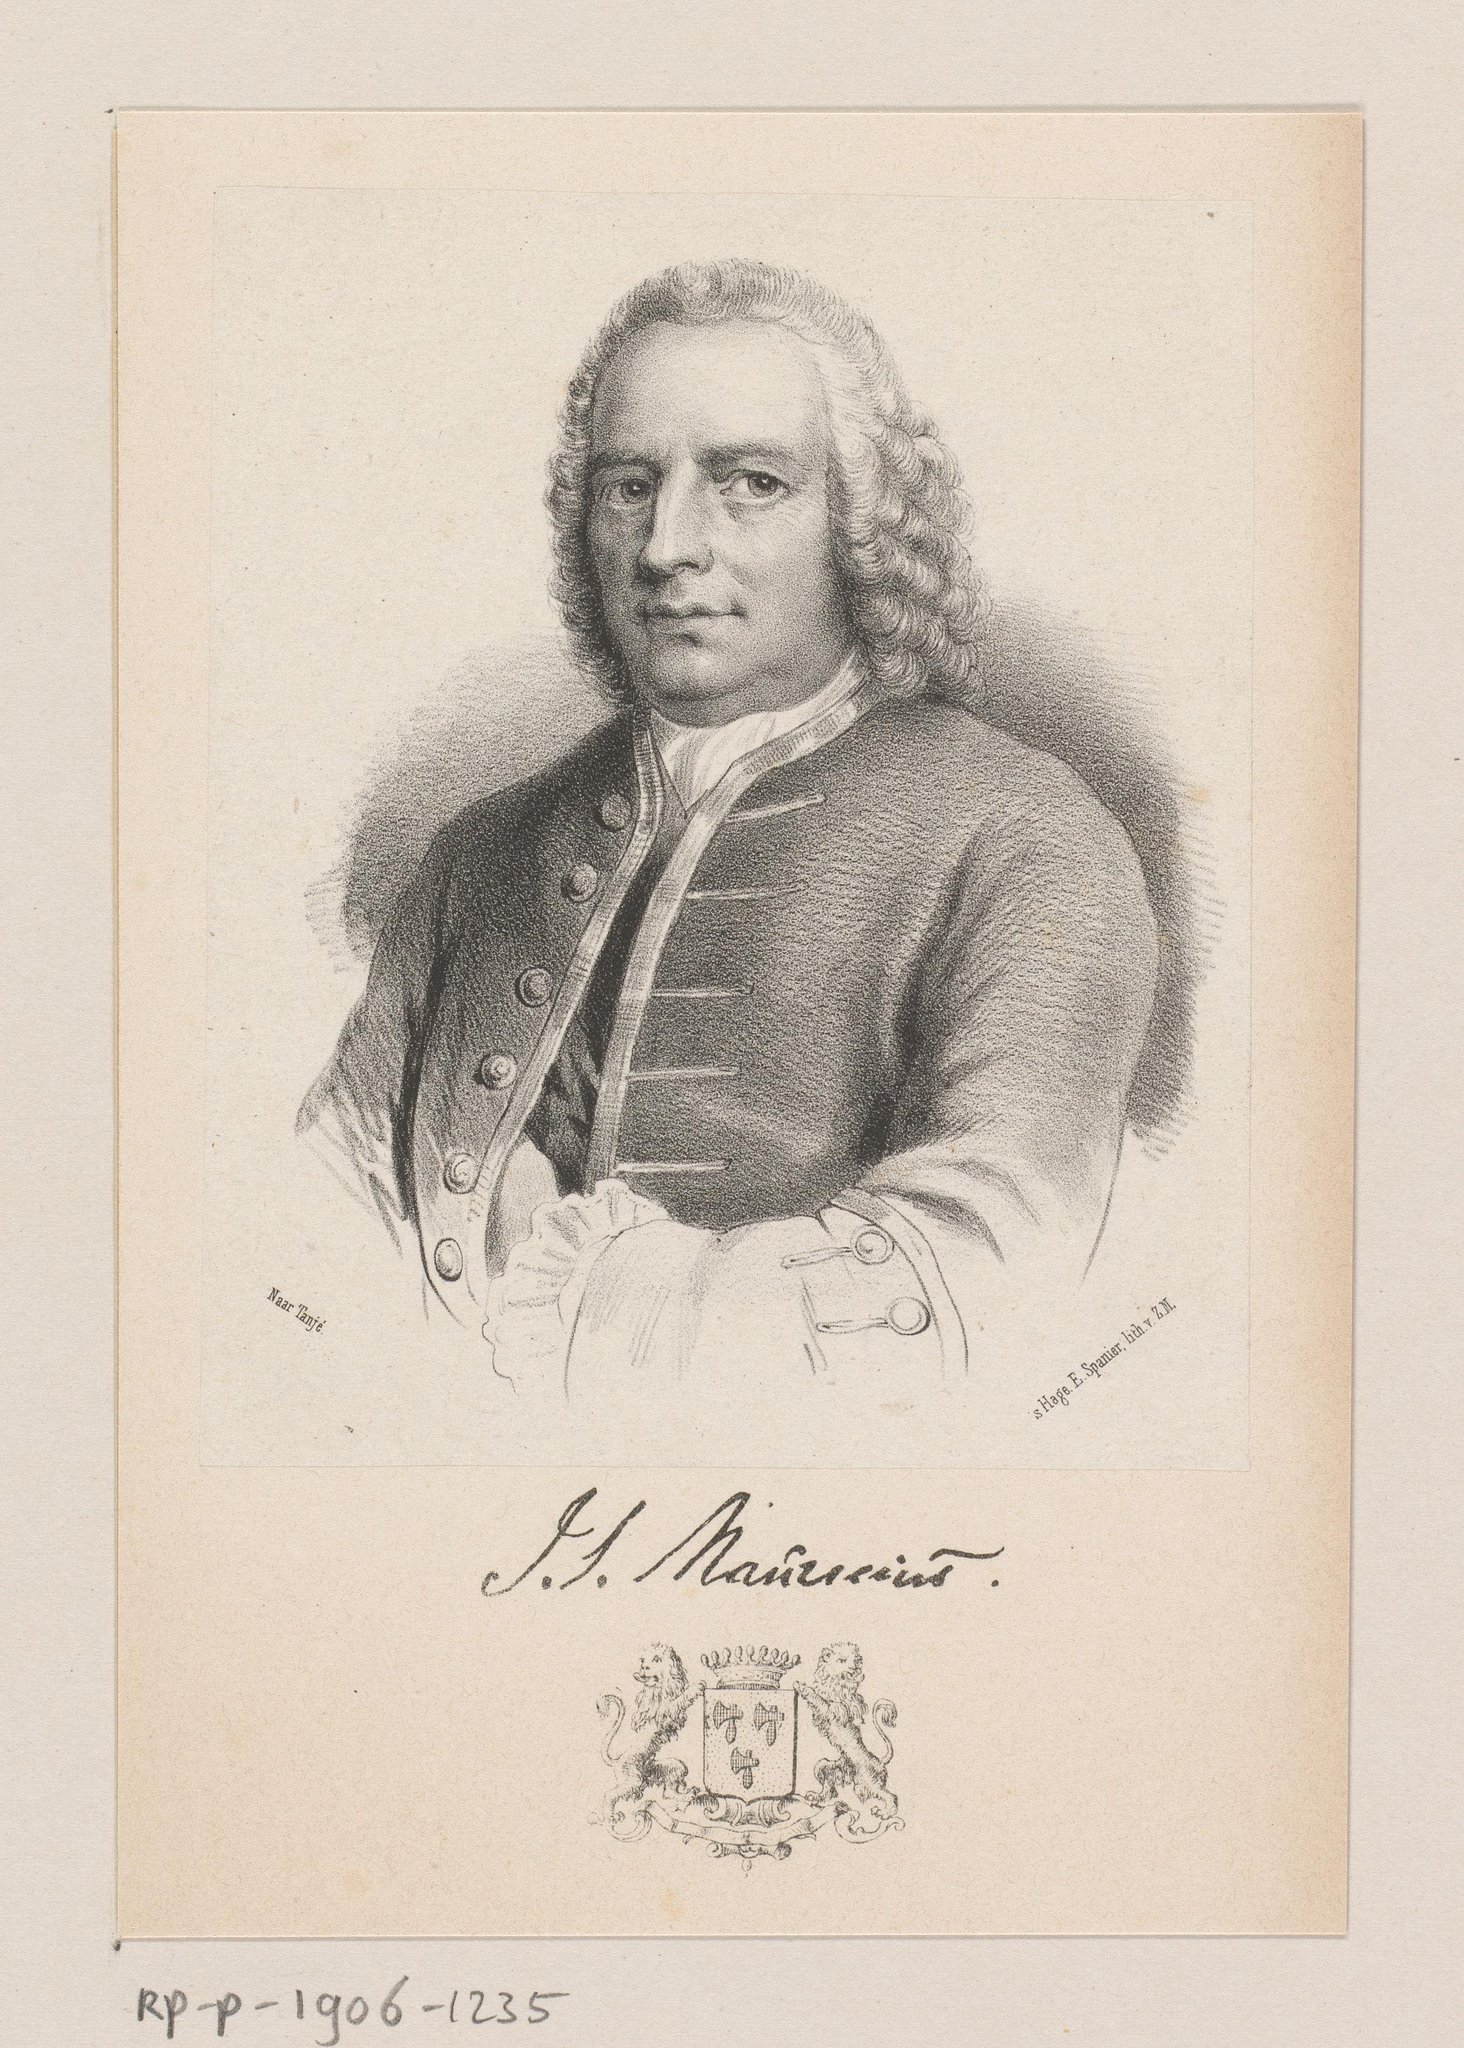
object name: print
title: Portret van Jan Jacob Mauricius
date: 1851-1863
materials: paper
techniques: lithograph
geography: the hague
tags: joan jacob mauricius, colonial governor, historical persons, portrait of a writer, armorial bearing, heraldry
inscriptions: collector's mark: Lugt 2228